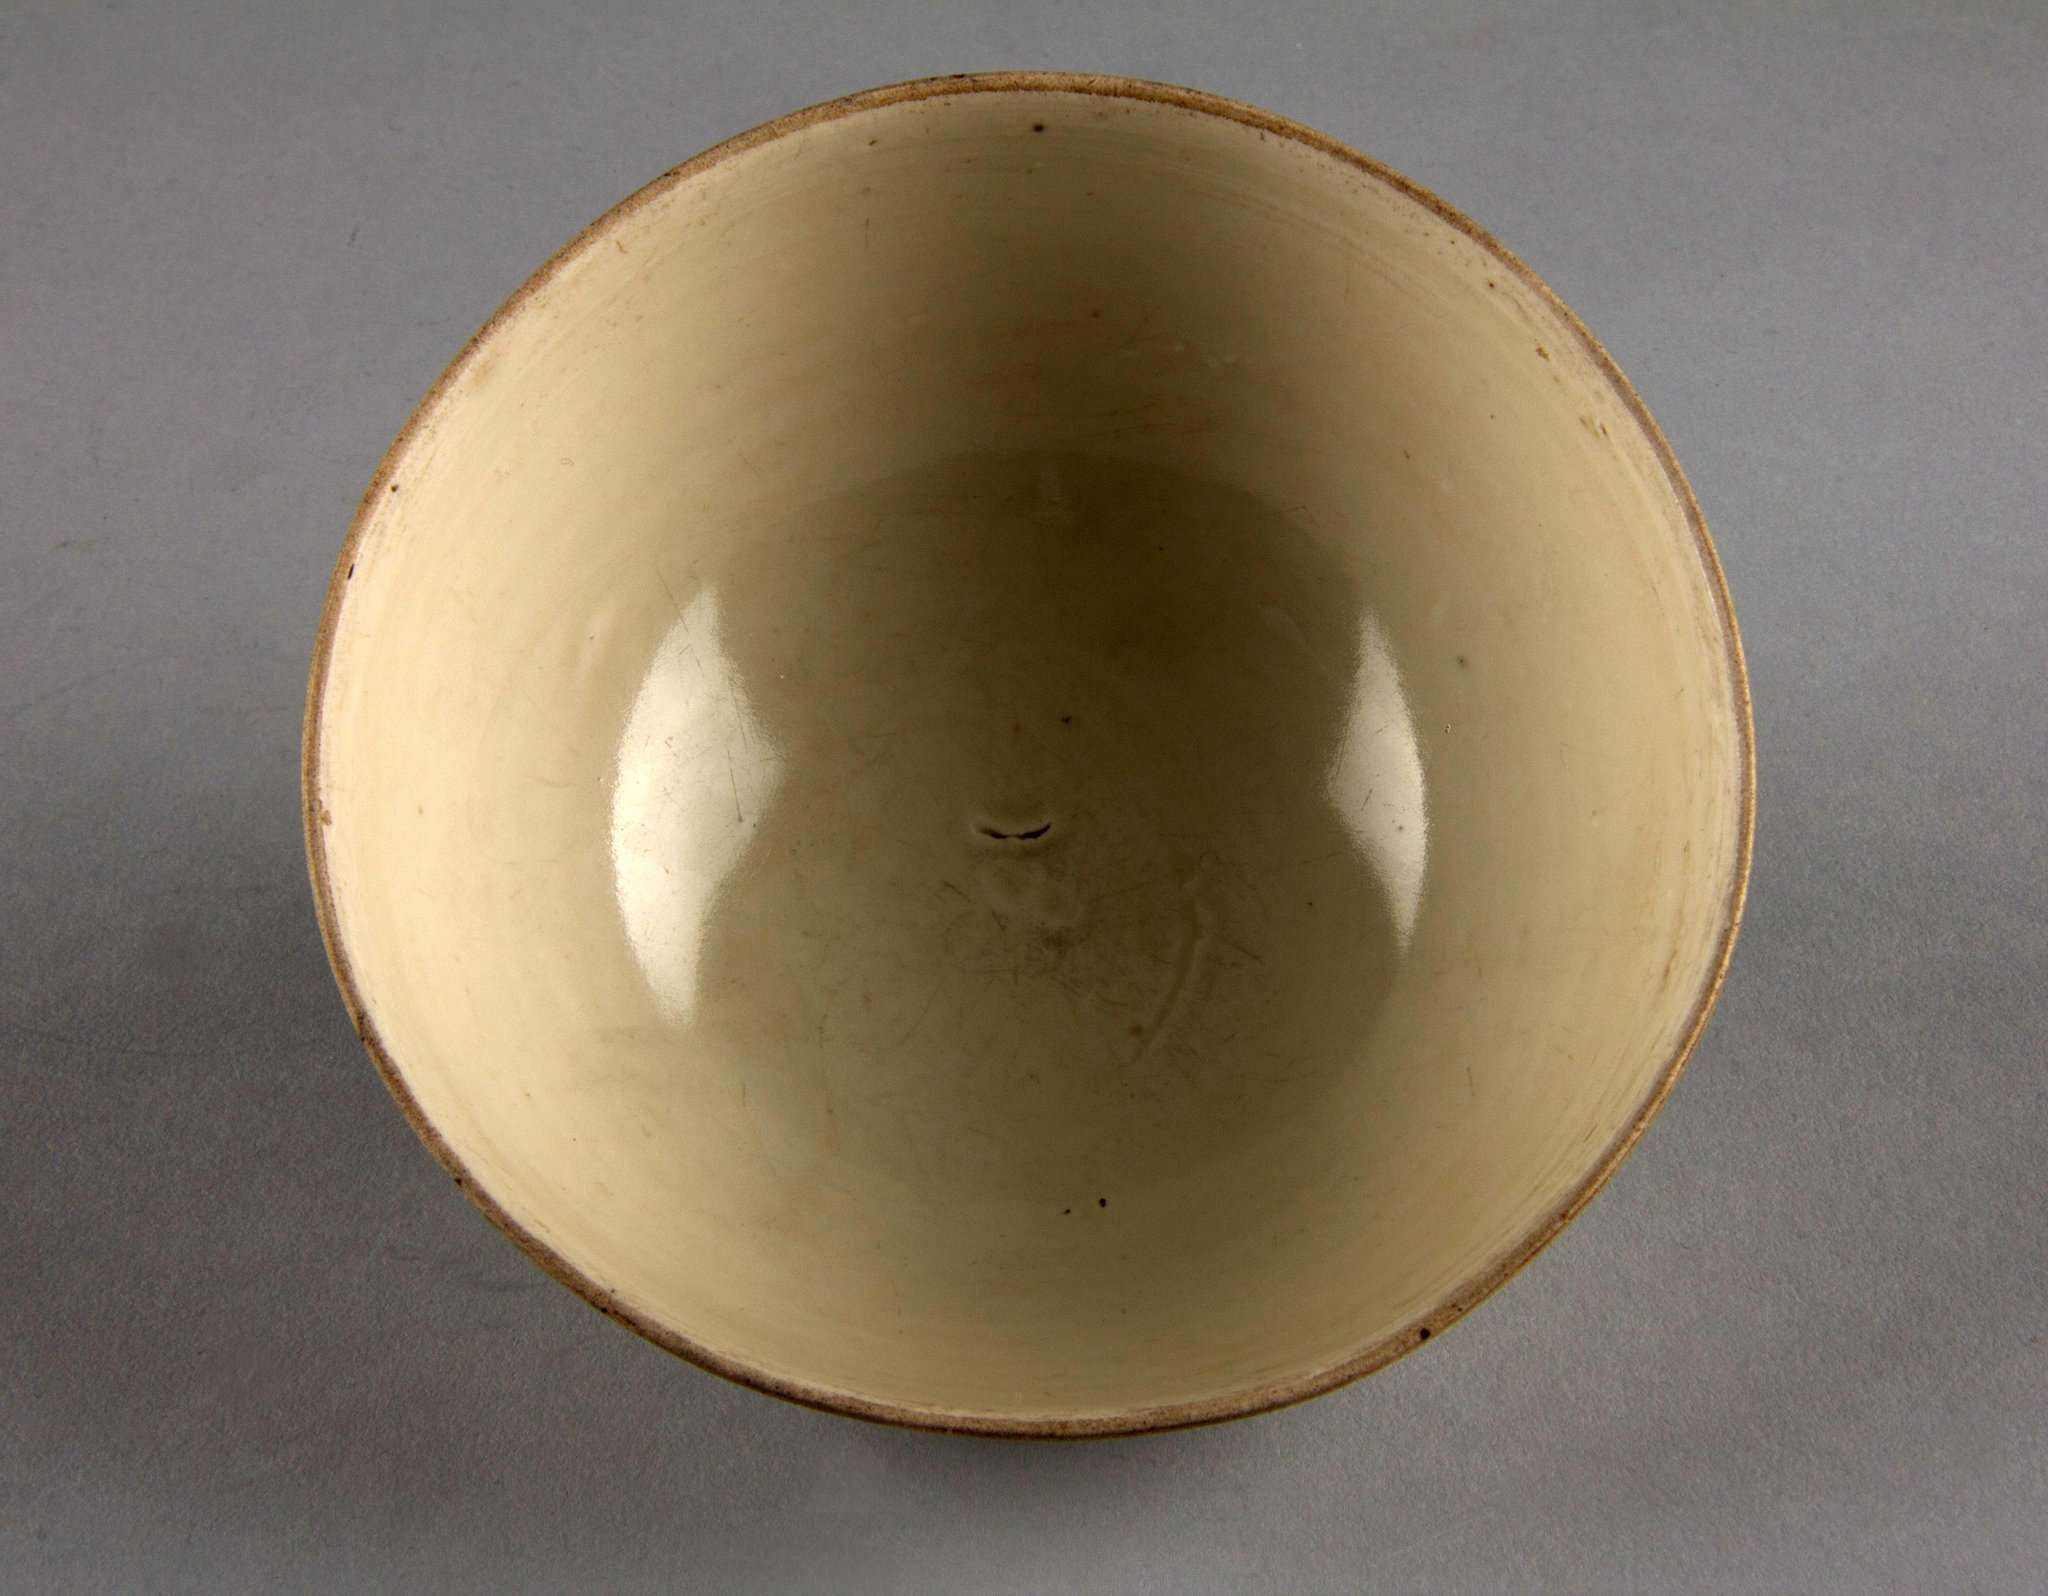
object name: bowl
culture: chinese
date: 1101-1300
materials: glaze, porcelain